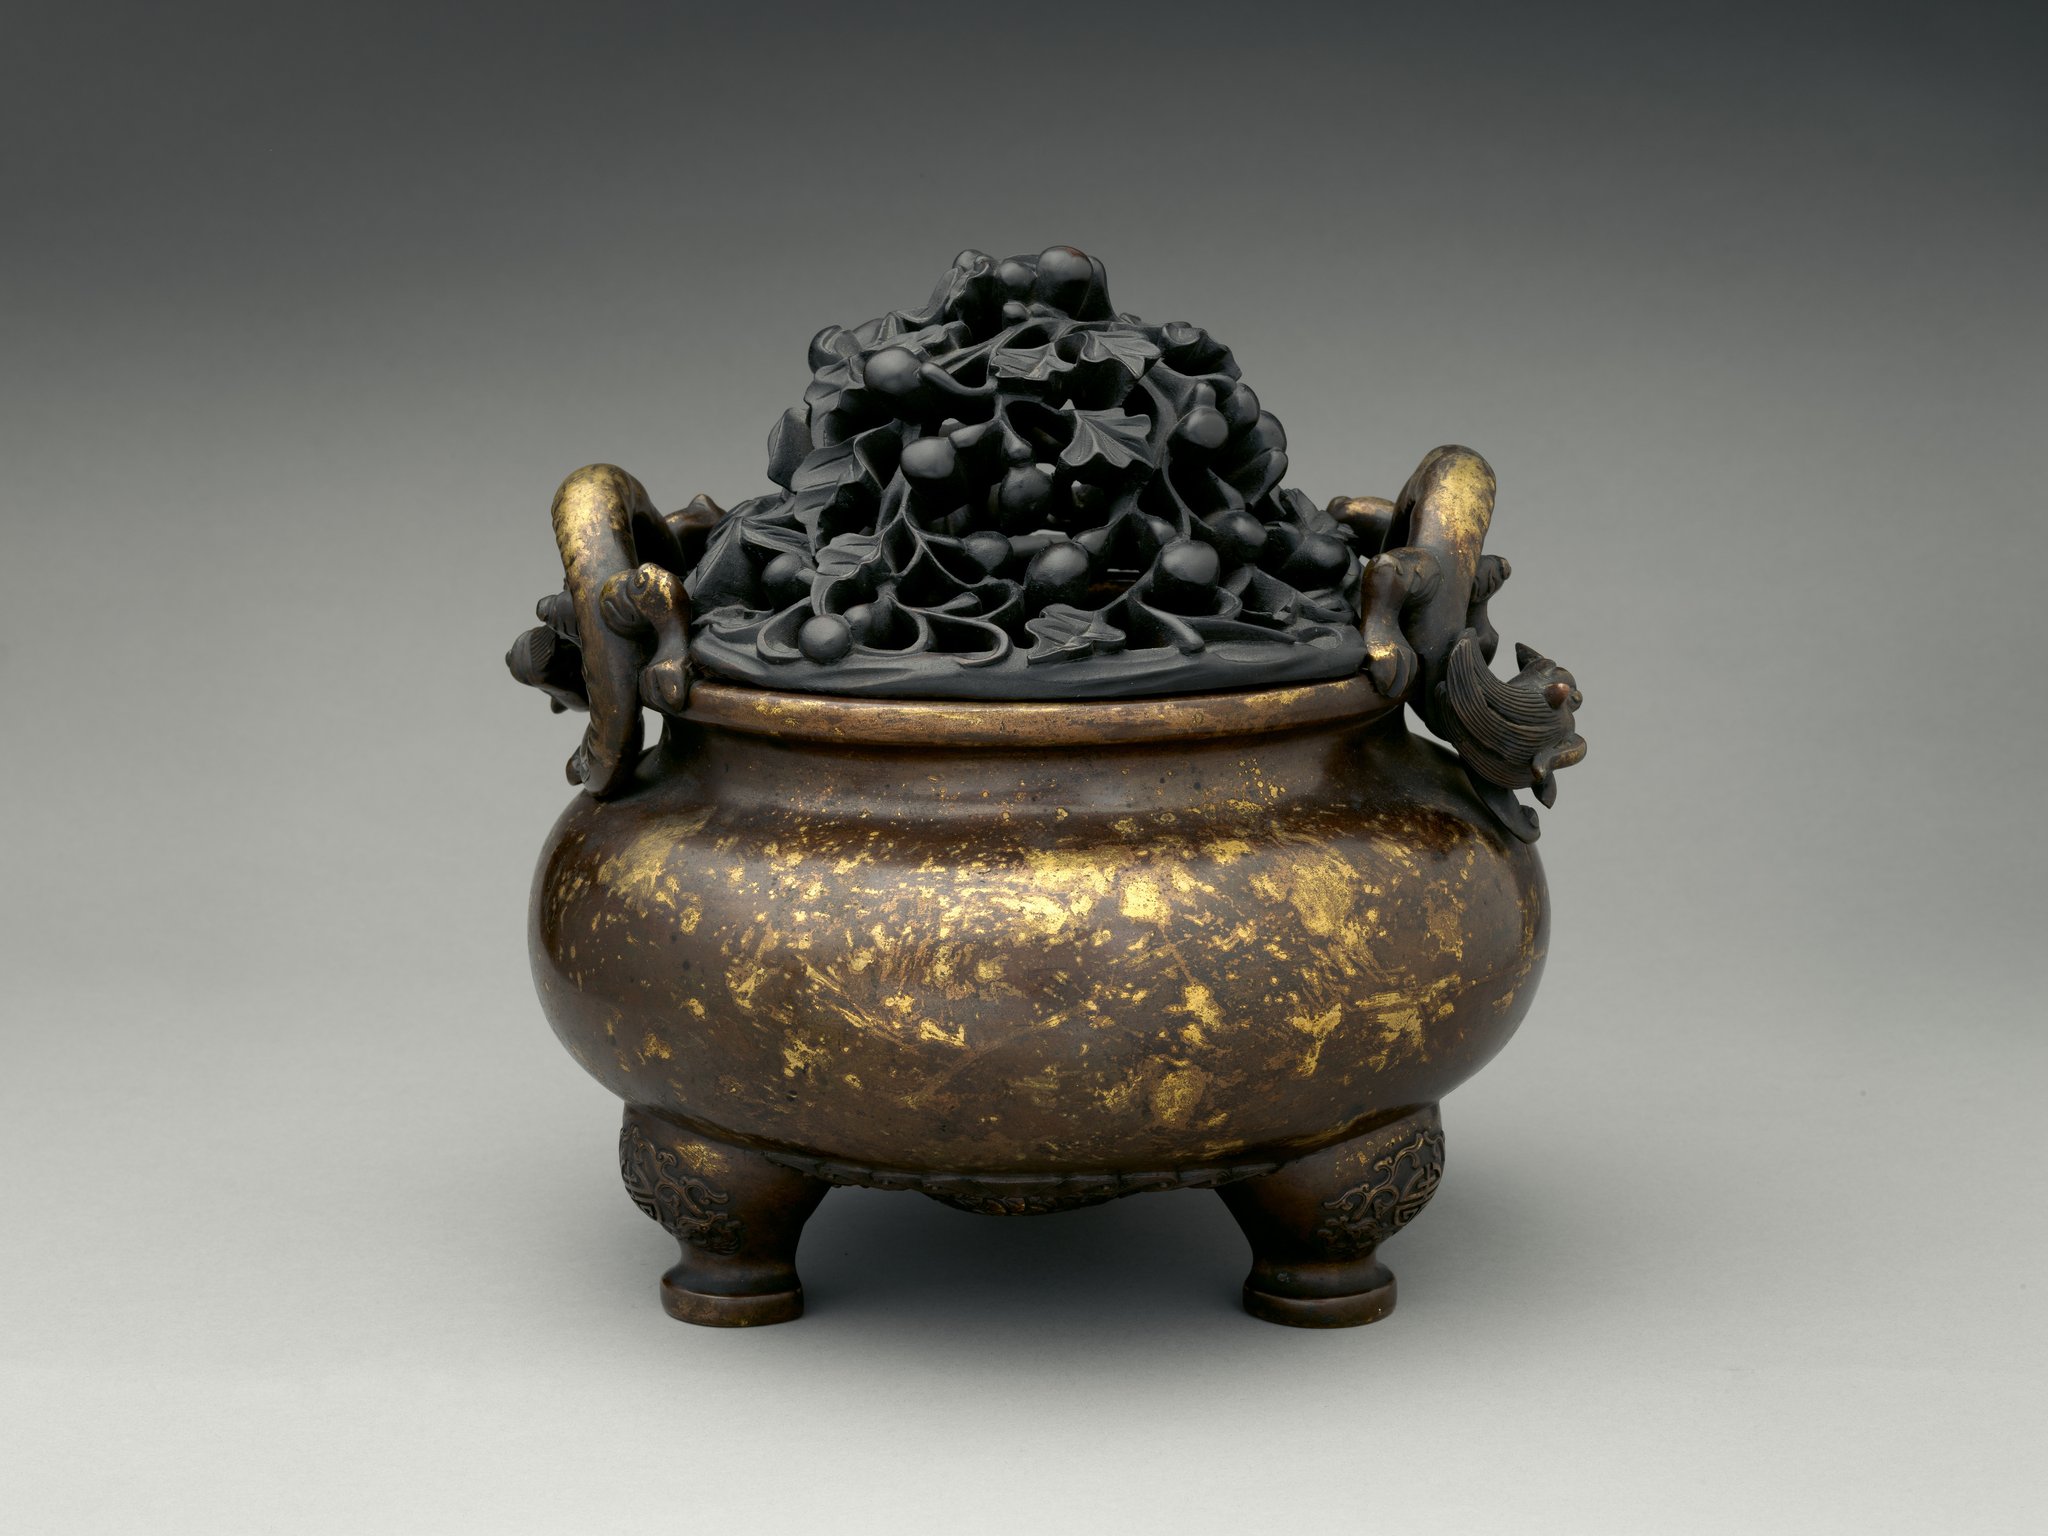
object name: incense burner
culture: chinese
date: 1701-1800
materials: copper alloy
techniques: gilding